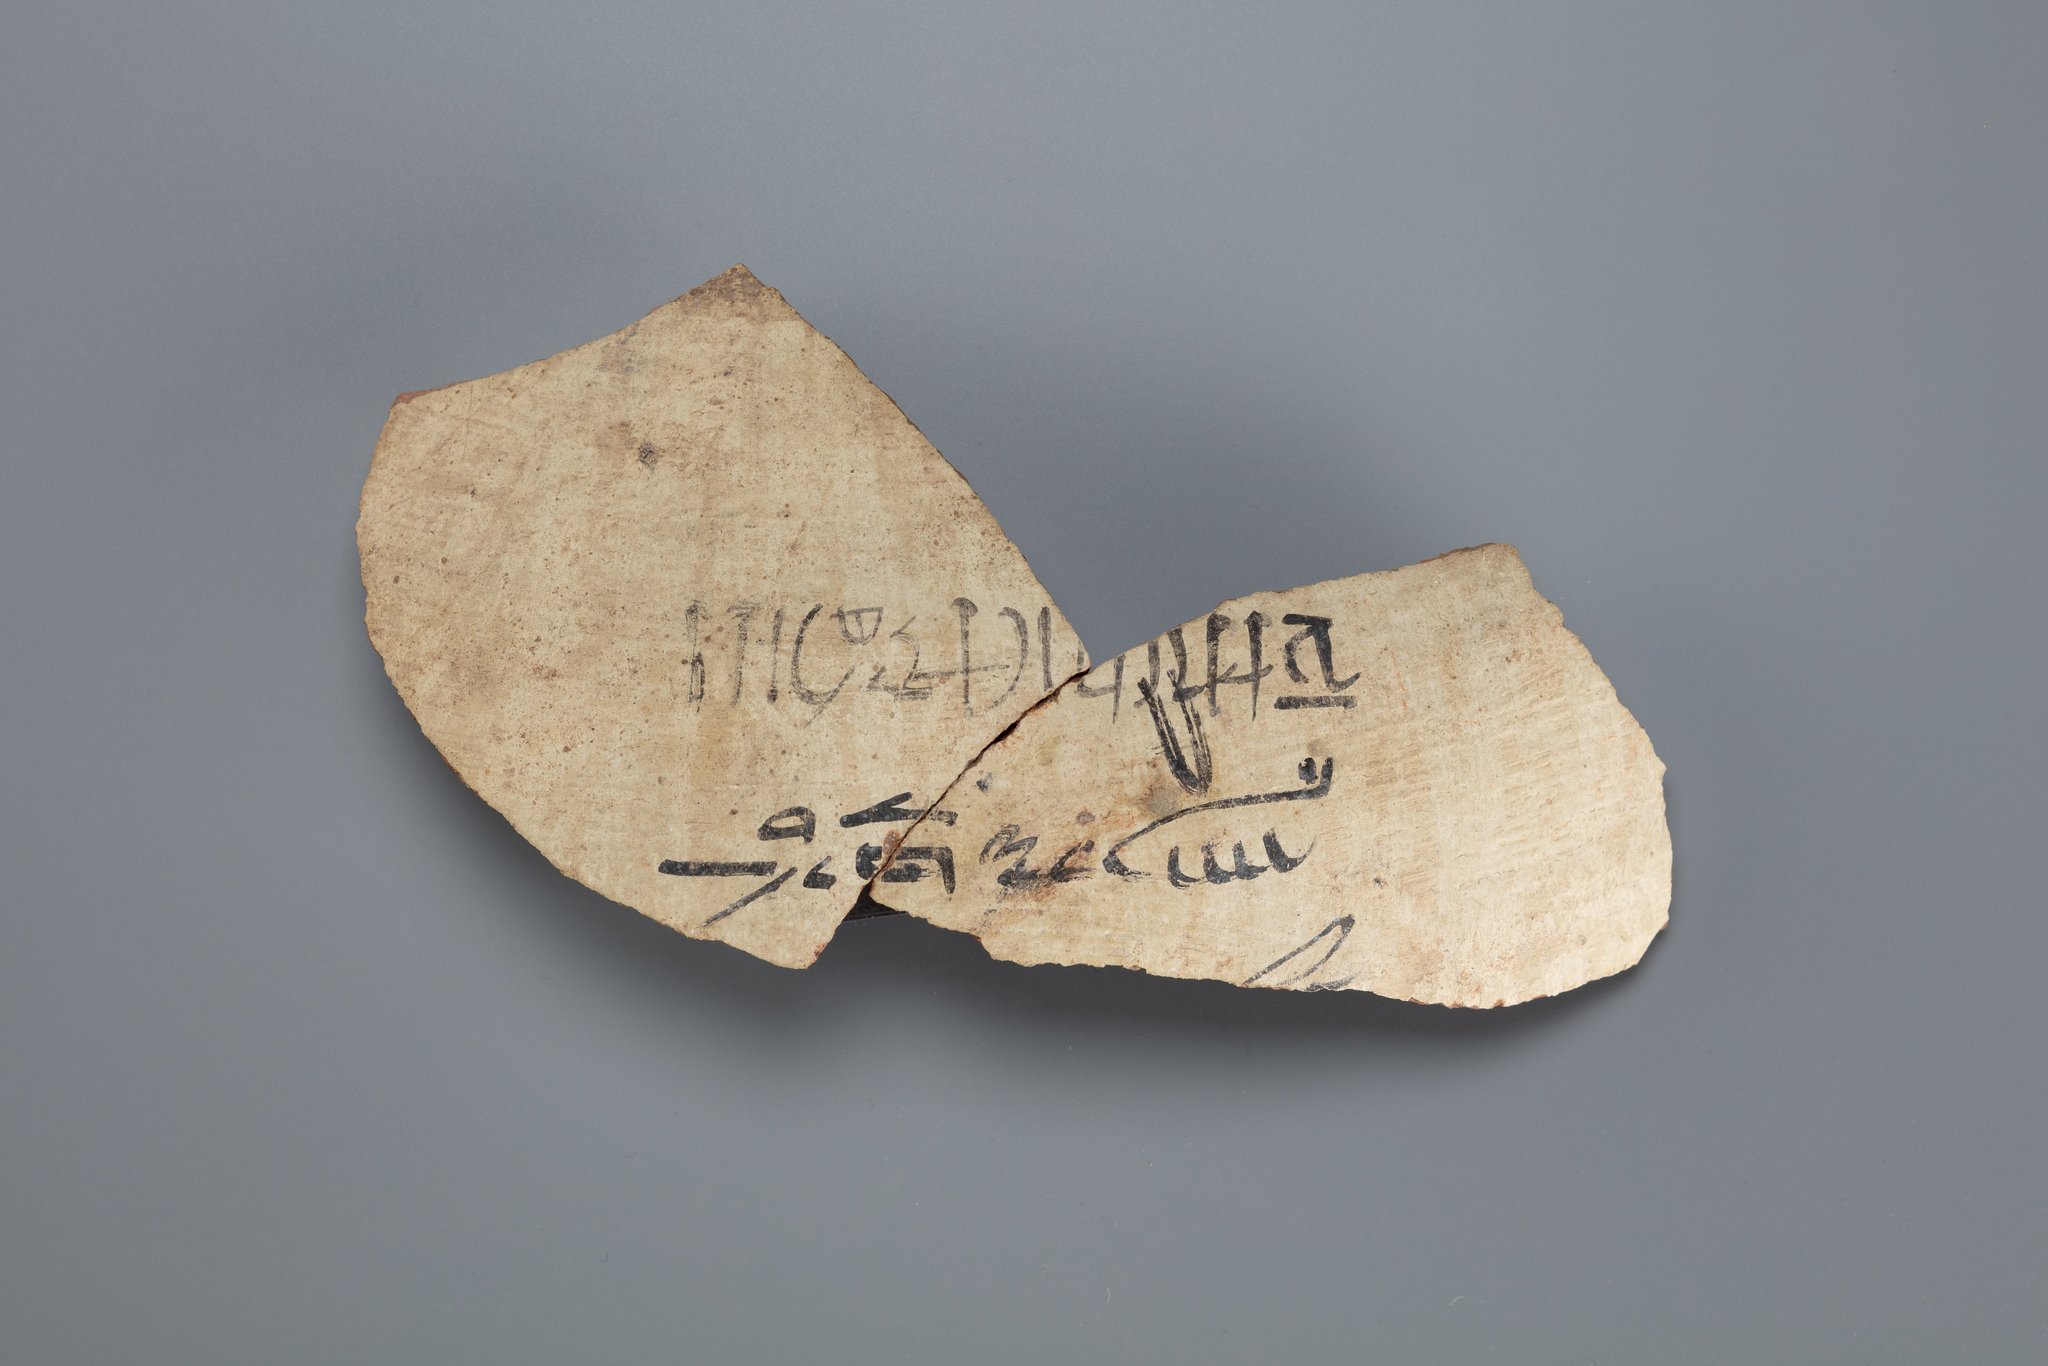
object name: jar label, honey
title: Fragement from a jar with a label identifying contents as honey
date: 1390-1352 BCE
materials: ink, pottery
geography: egypt